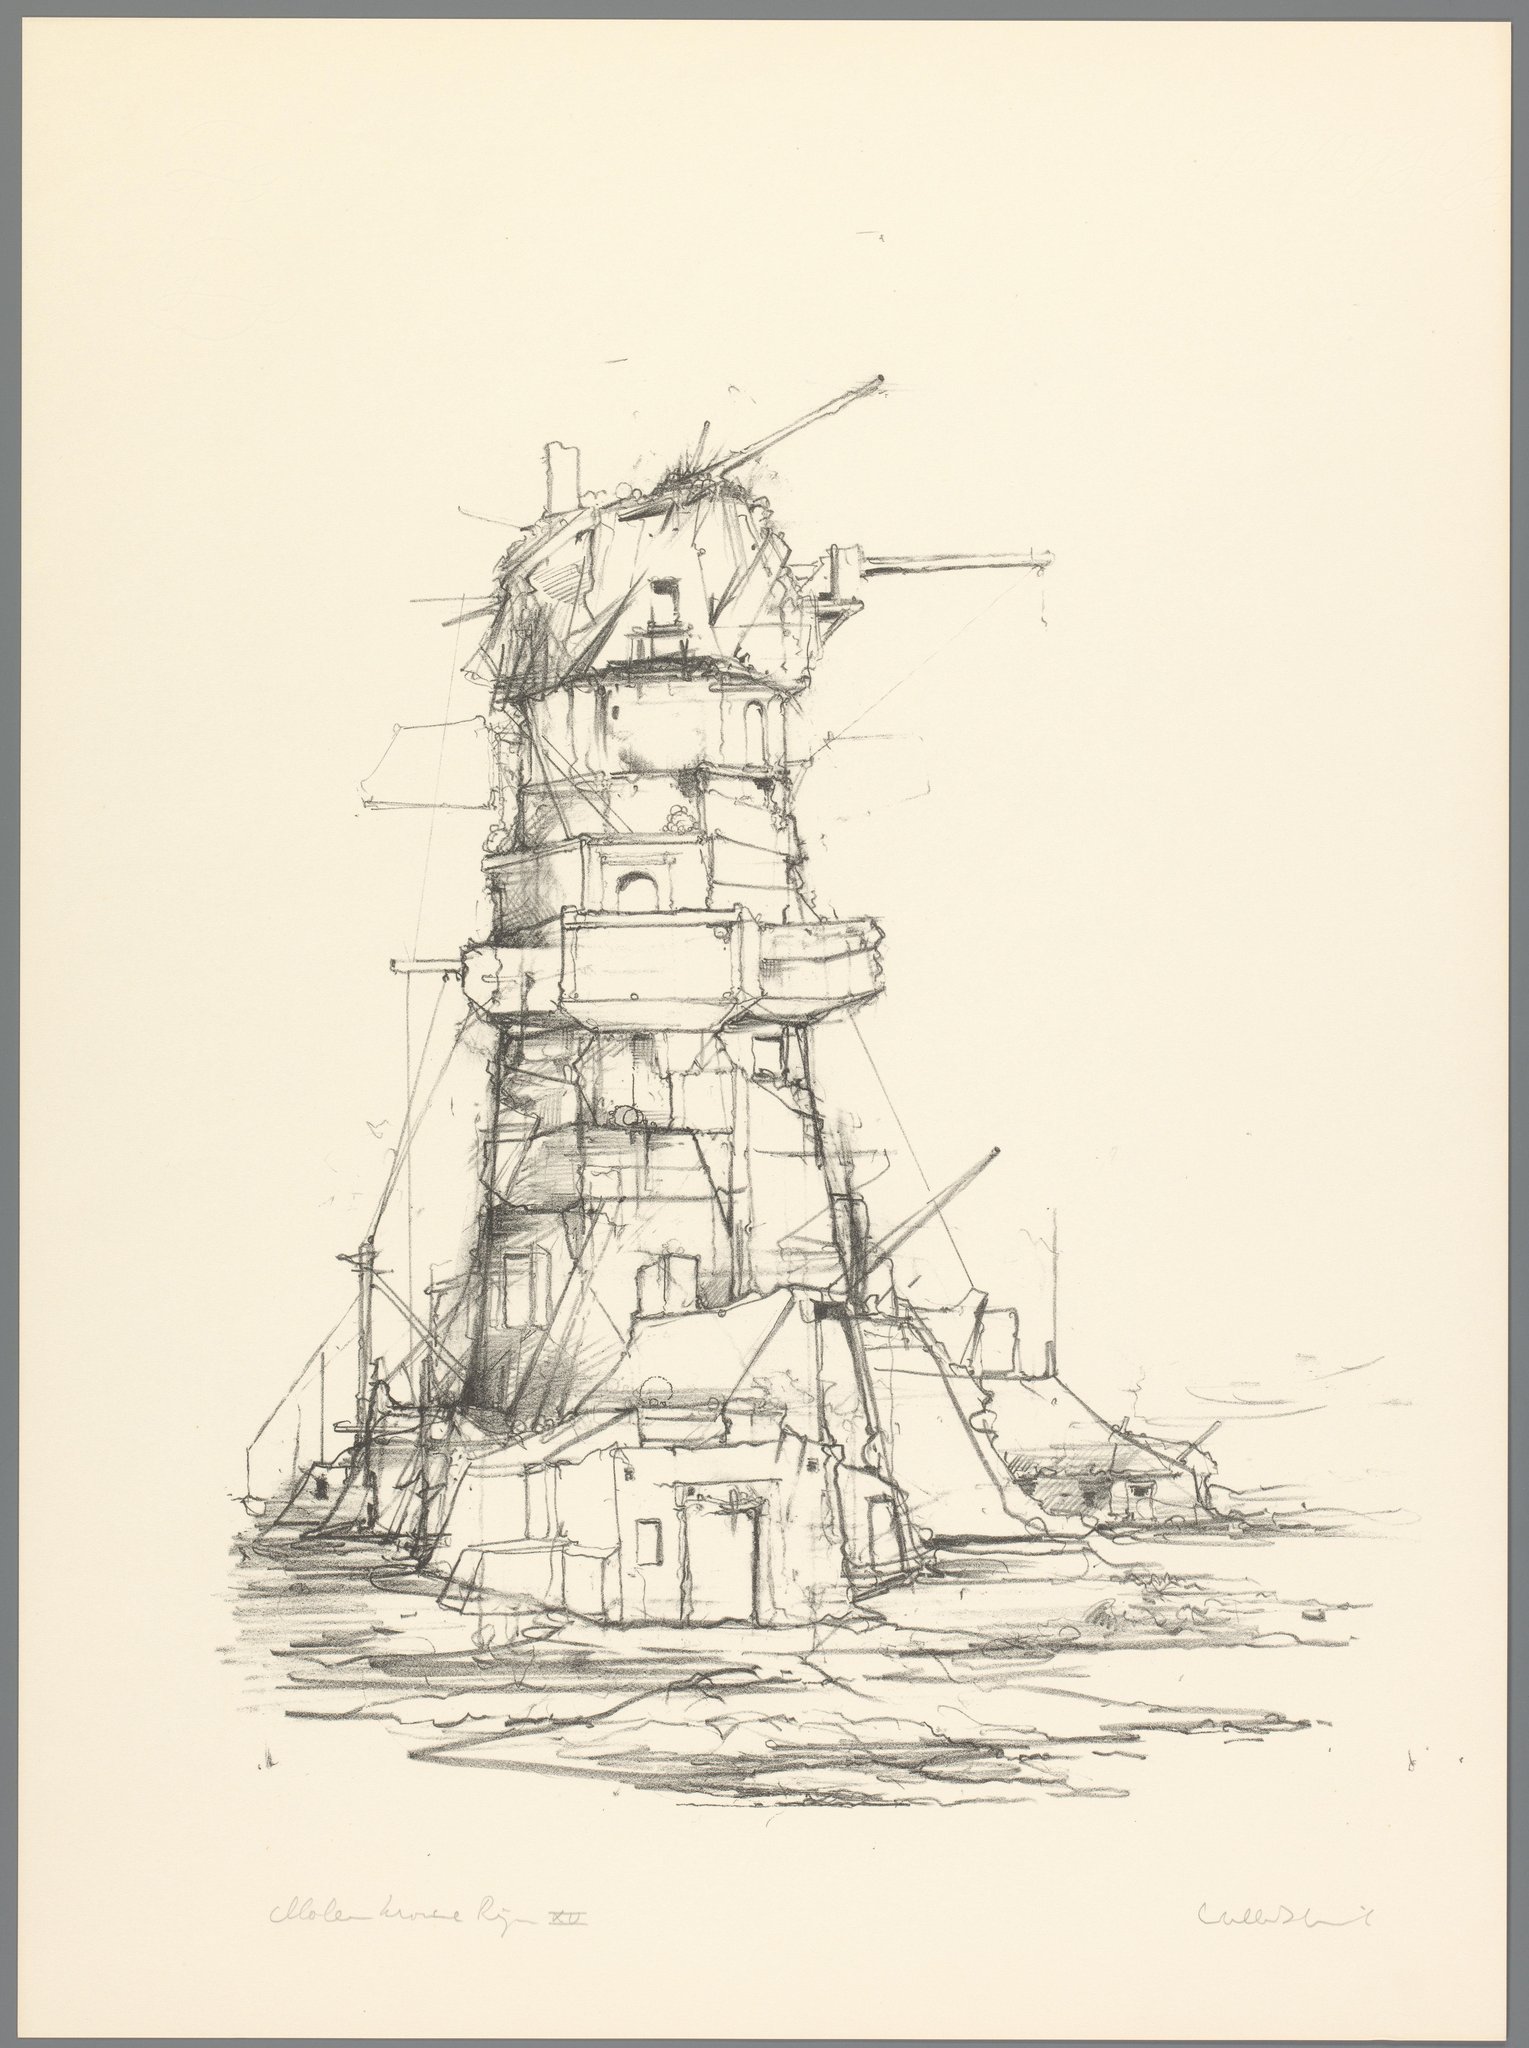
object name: print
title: Tien gezichten op Utrecht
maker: dirkje kuik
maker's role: print maker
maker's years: 1929-2008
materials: ink, paper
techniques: lithograph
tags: watermill in landscape - ii - ideal landscapes, city-view in general; 'veduta' - ii - ideal city, utrecht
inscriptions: signature: ‘WillDkuik’, title: ‘Molen Kromme Rijn’, edition: ‘XV’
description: Molen zonder wieken, met enkele spanningsdraden.